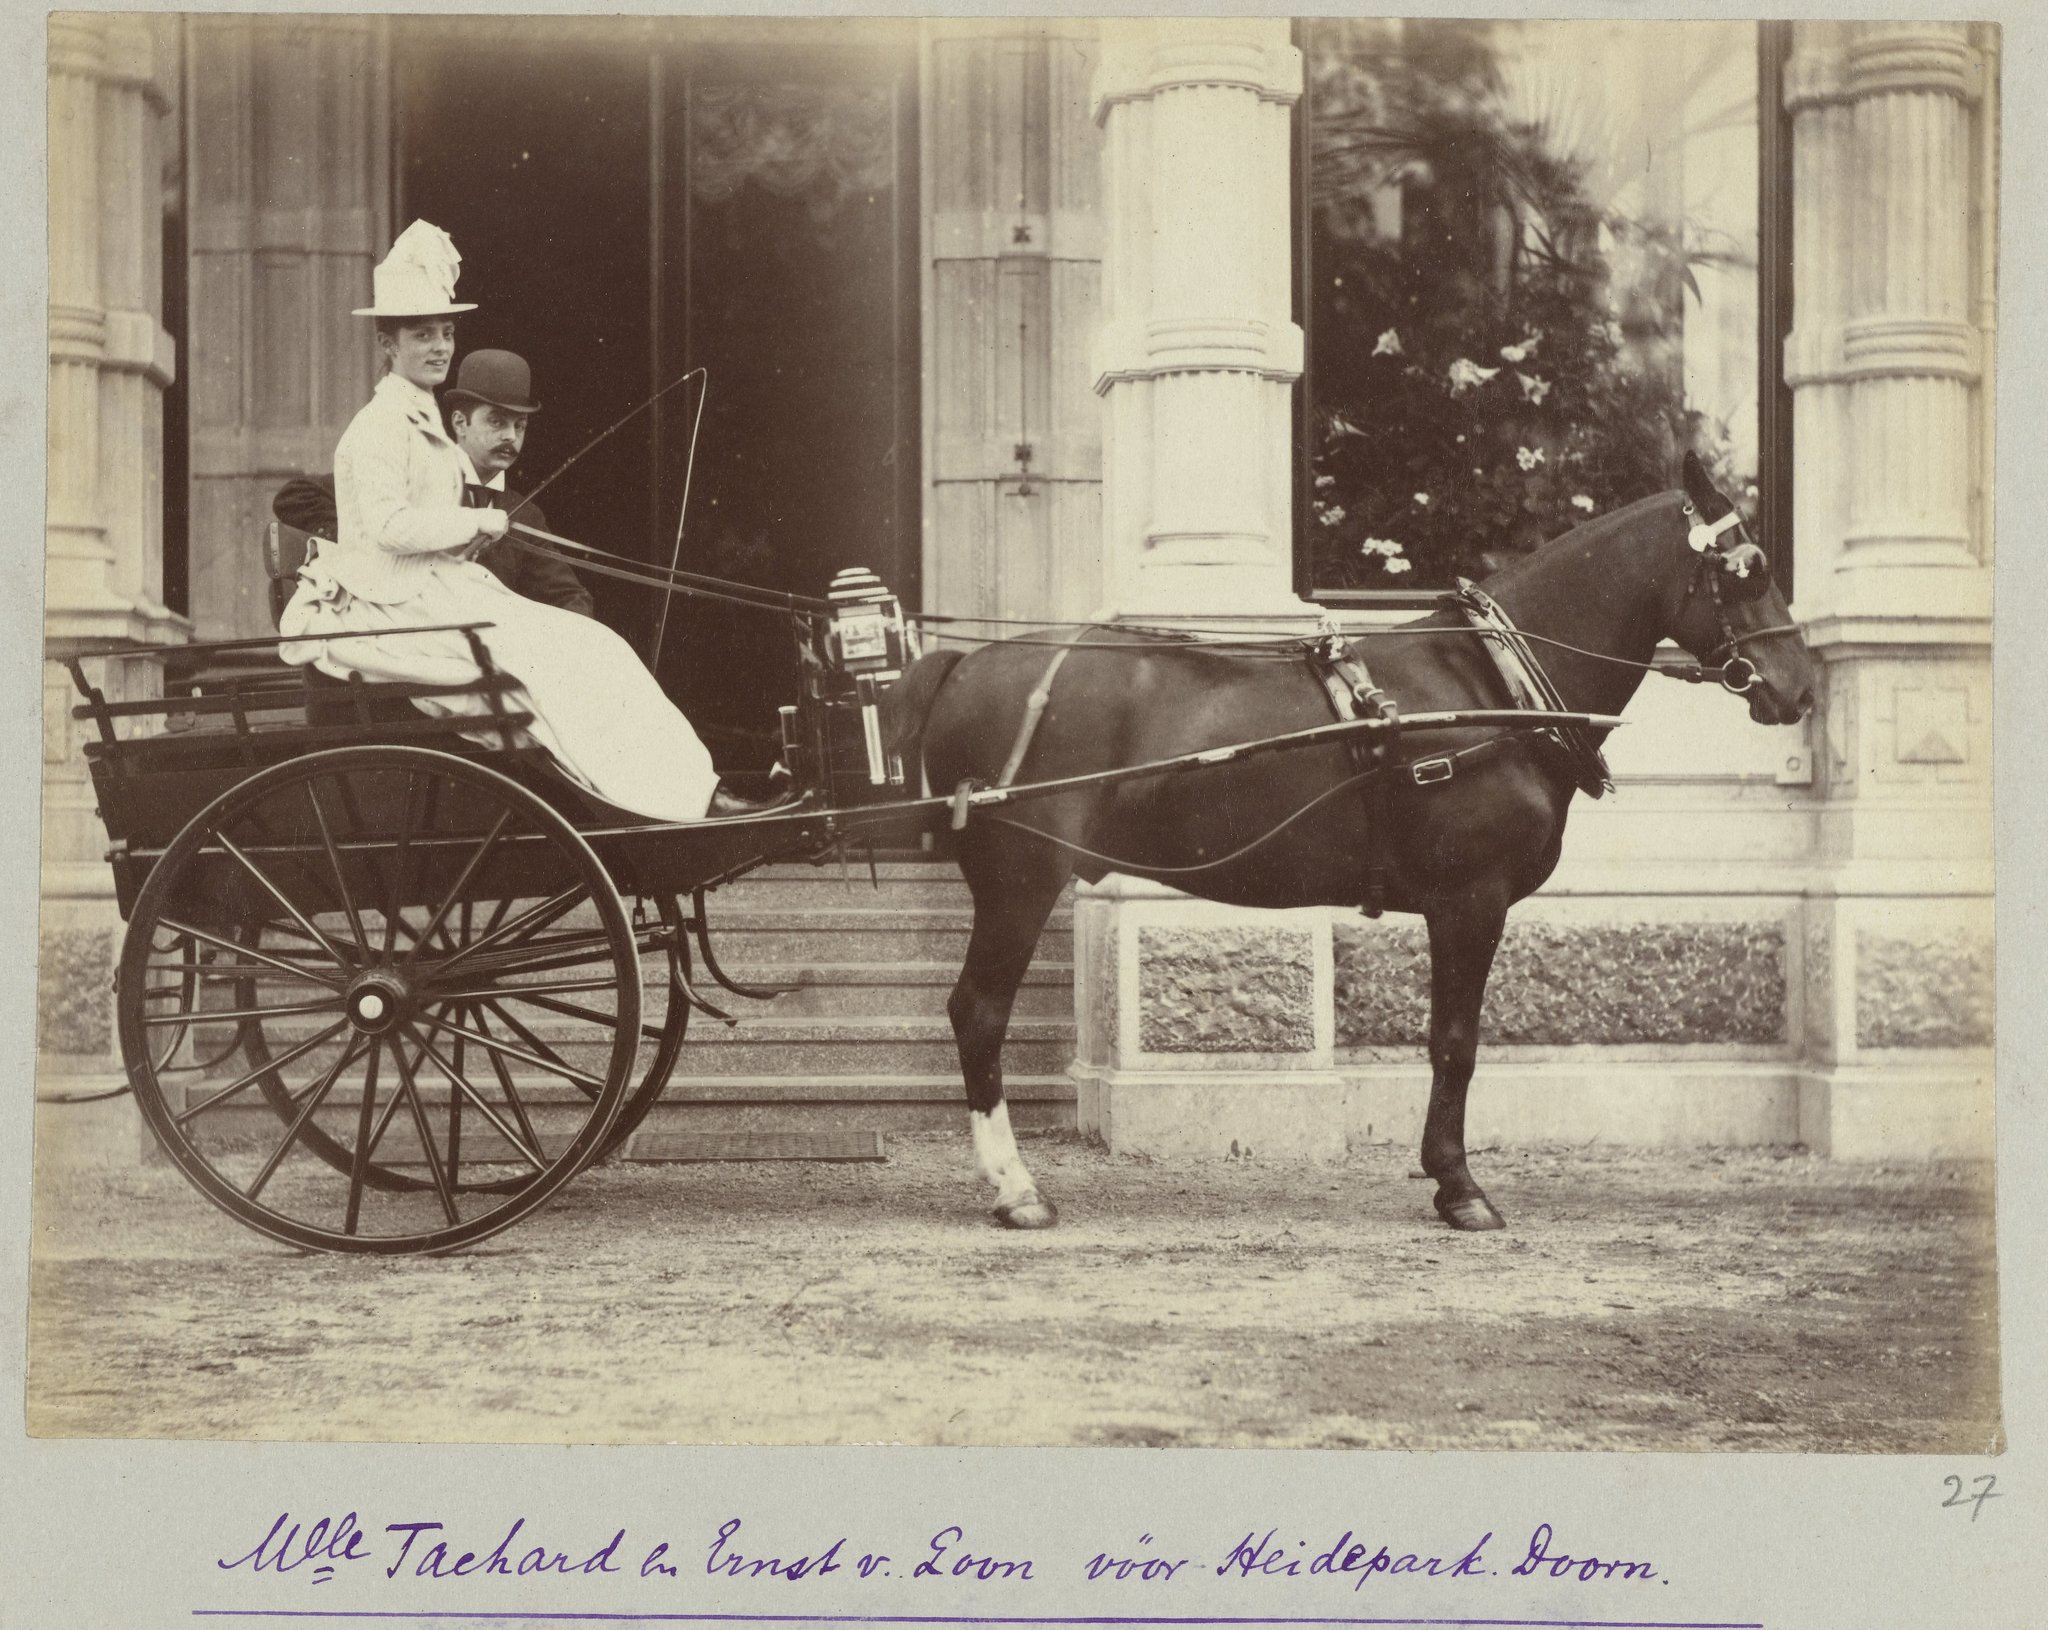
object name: photograph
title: Mejuffrouw Tachard en Ernst van Loon in een rijtuig voor huis Hydepark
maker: henry pauw van wieldrecht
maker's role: fotograaf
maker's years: 1863-1912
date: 1888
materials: paper, photographic support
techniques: albumen print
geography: netherlands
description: Met onderschrift: Mme Tachard en Ernst v. Loon voor Heidepark Doorn.